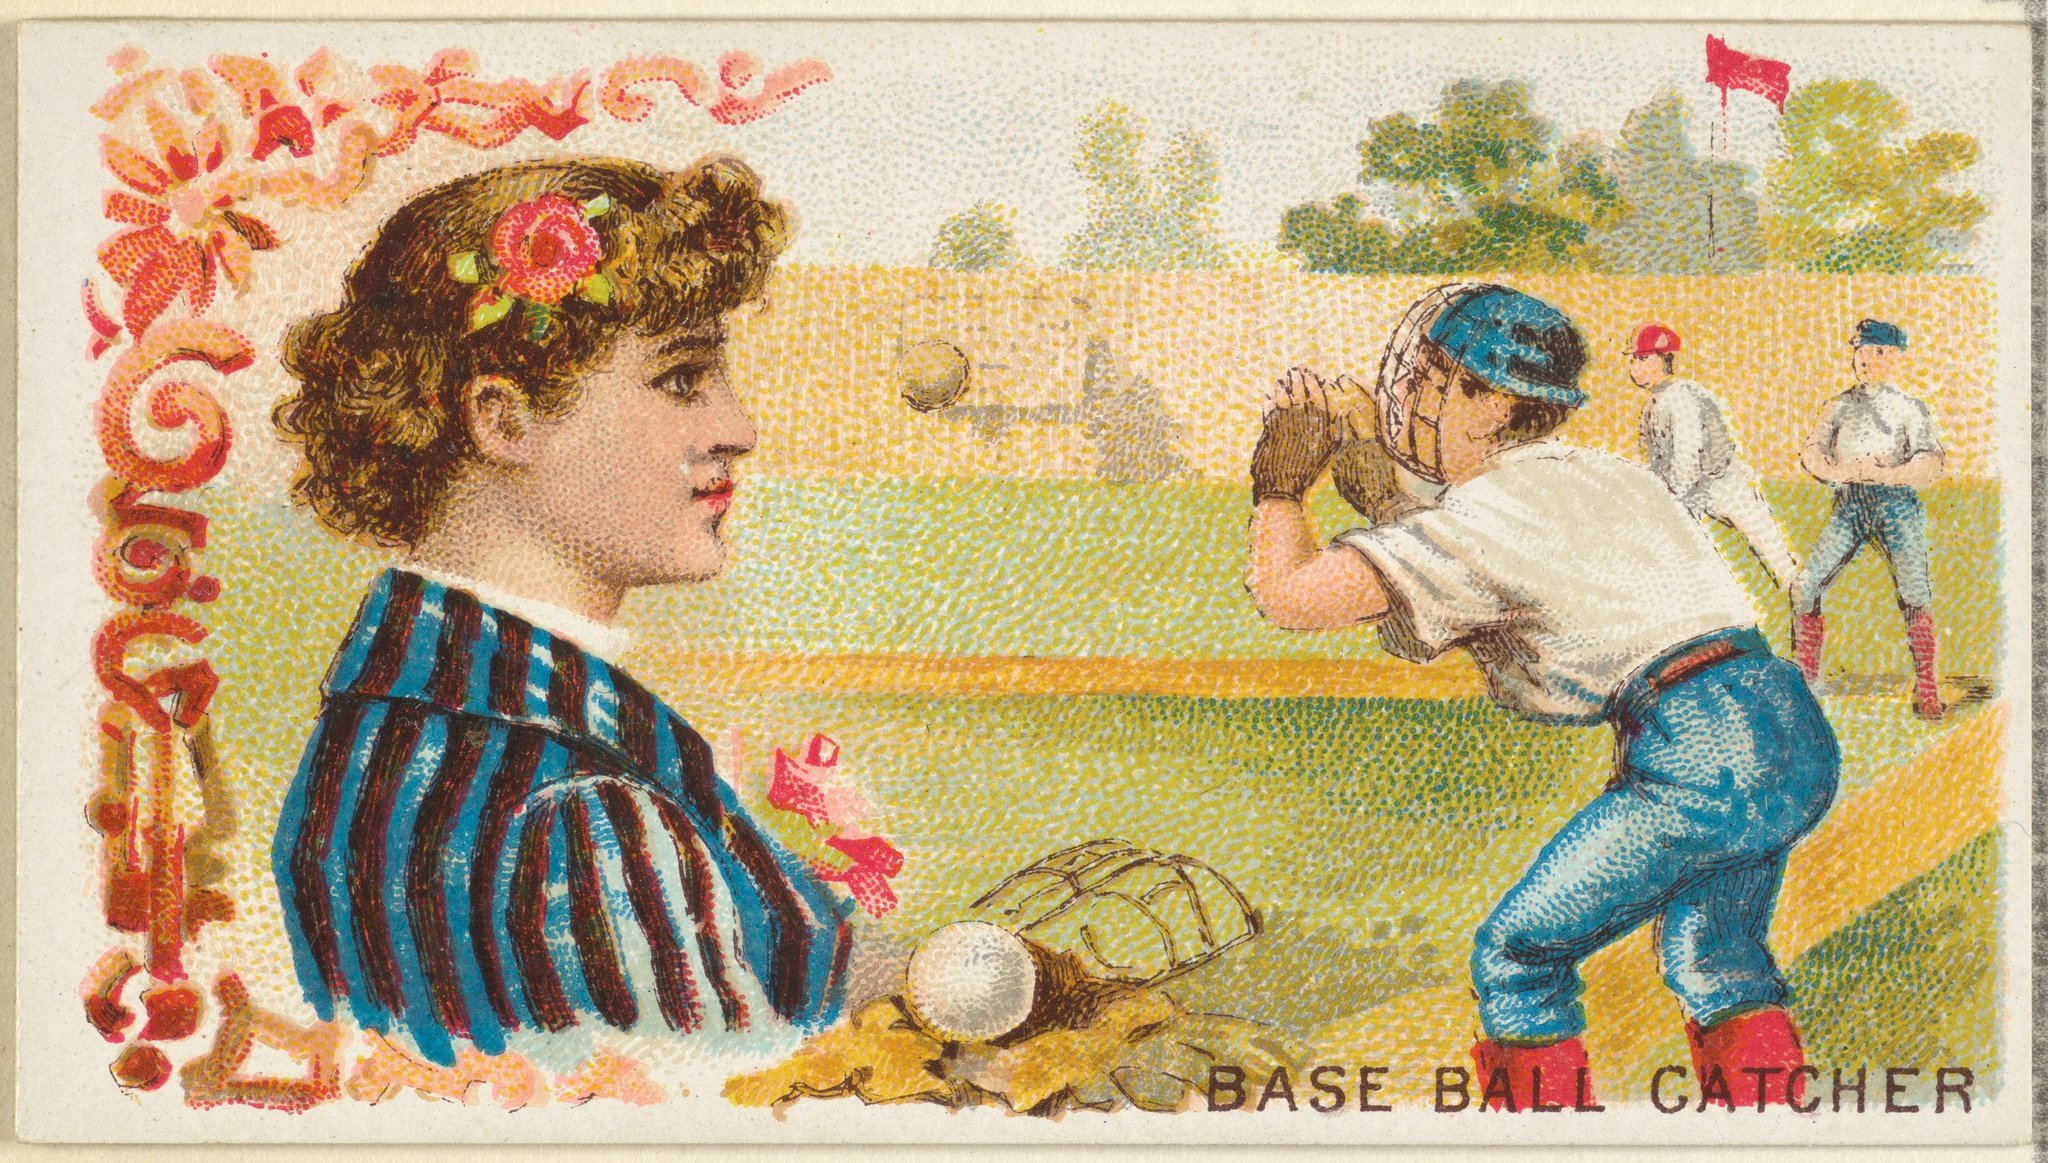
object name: baseball card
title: Baseball Catcher, from the Games and Sports series (N165) for Old Judge Cigarettes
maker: goodwin & company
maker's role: publisher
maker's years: 1850-1950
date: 1889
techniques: color lithograph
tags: men,women,baseball,athletes